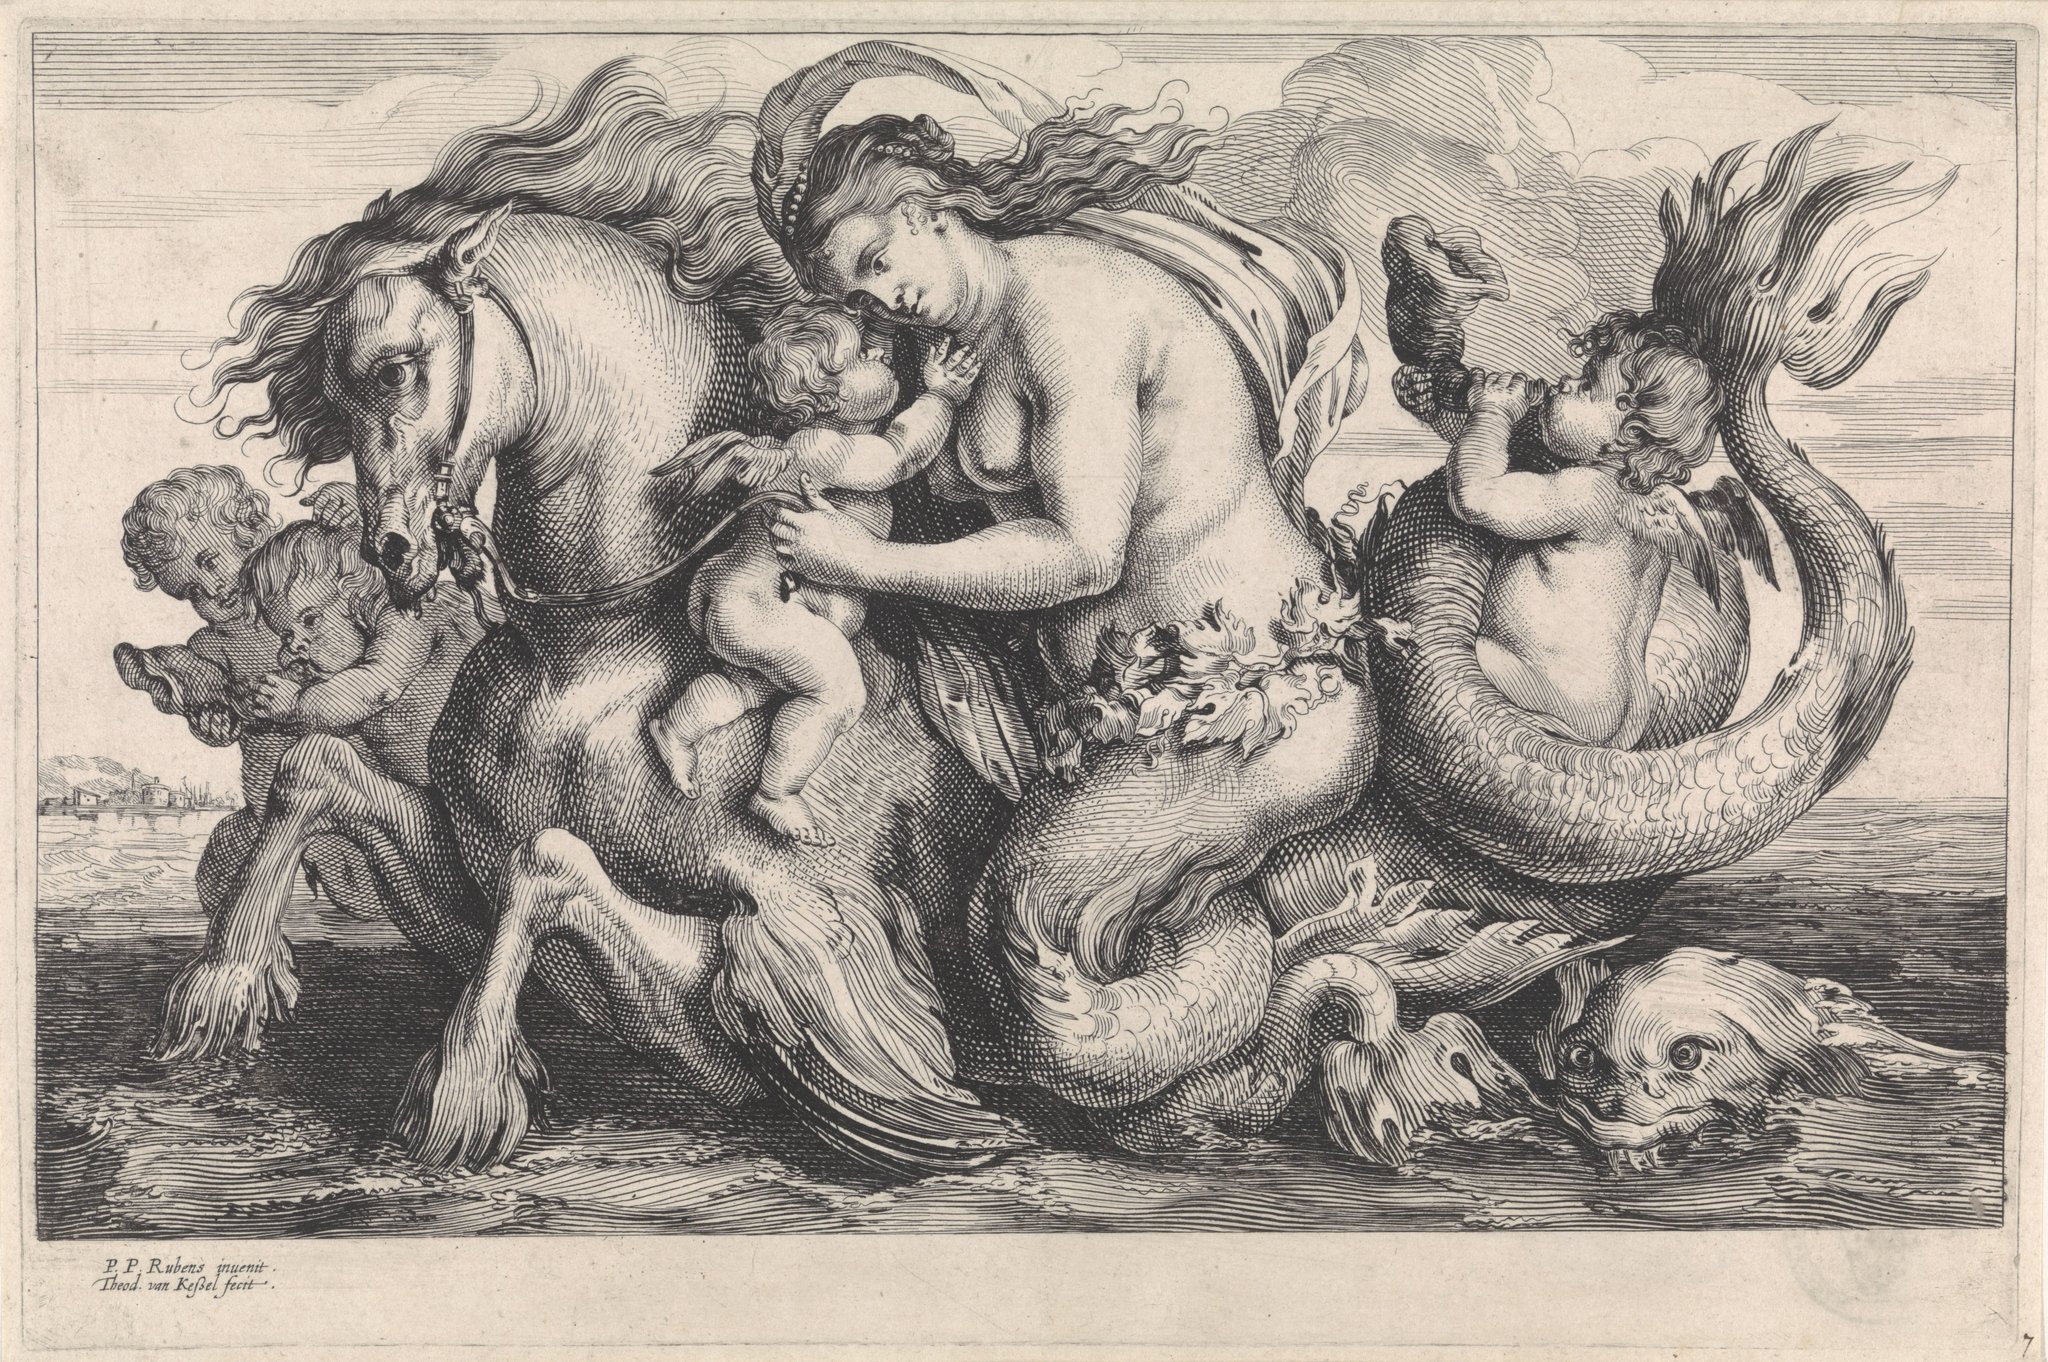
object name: print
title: Triomf van Galatea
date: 1630-1660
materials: paper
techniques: engraving, etching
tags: cupids: 'amores', 'amoretti', 'putti' (+ triumph), sea-horse, hippocamp, 'hippocampus', (horse/fish) (mythological hybrid monster), triumph of galatea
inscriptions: collector's mark: Lugt 10, collector's mark: Lugt 11, inscription: ‘7’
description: De triomf van de zeegodin Galatea. De naakte Galatea wordt door een zeepaard door het water gevoerd, terwijl ze wordt vergezeld door vier putti, waarvan twee op een schelp blazen. Deze prent maakt deel uit van een vierdelige serie over mythologische figuren.